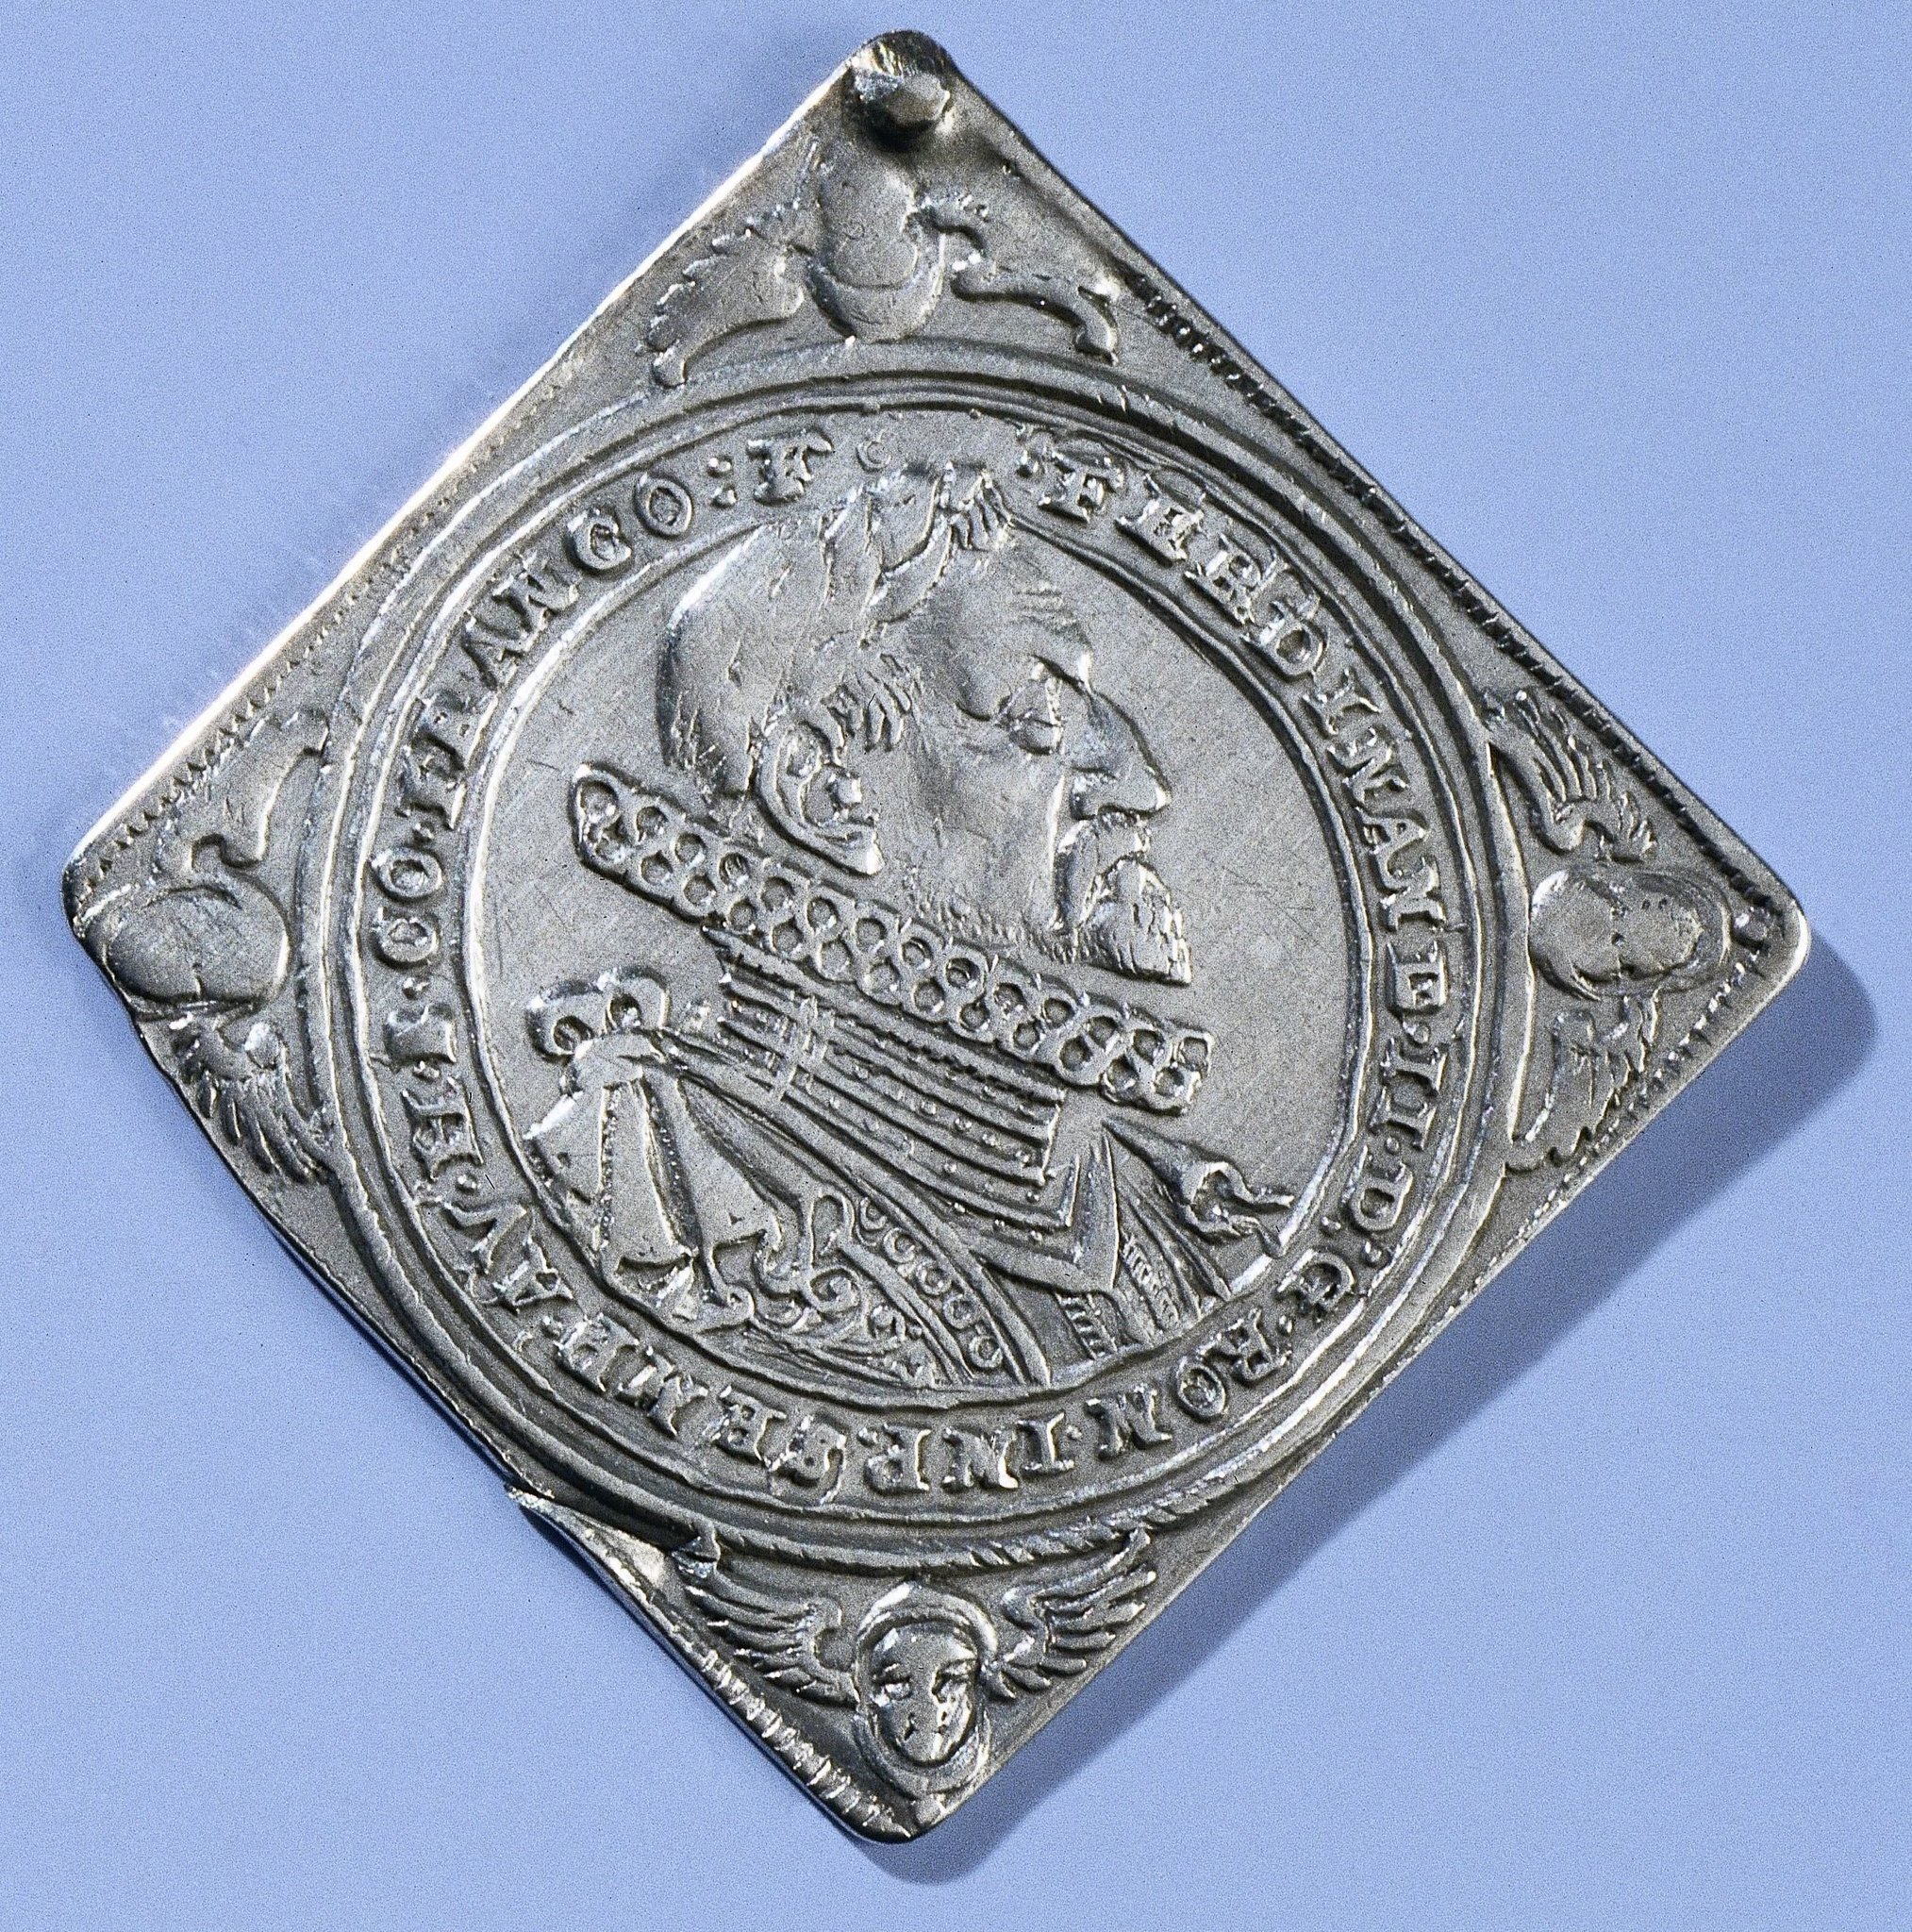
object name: history medal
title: Kroning van Ferdinand II tot Duits keizer te Frankfurt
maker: Anonymous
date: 1619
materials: silver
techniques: striking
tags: ferdinand ii (duits keizer)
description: Ruitvormige zilveren penning. Voorzijde: borststuk man. Keerzijde: kroon op gekruist zwaard en scepter, belicht door stralende zon.